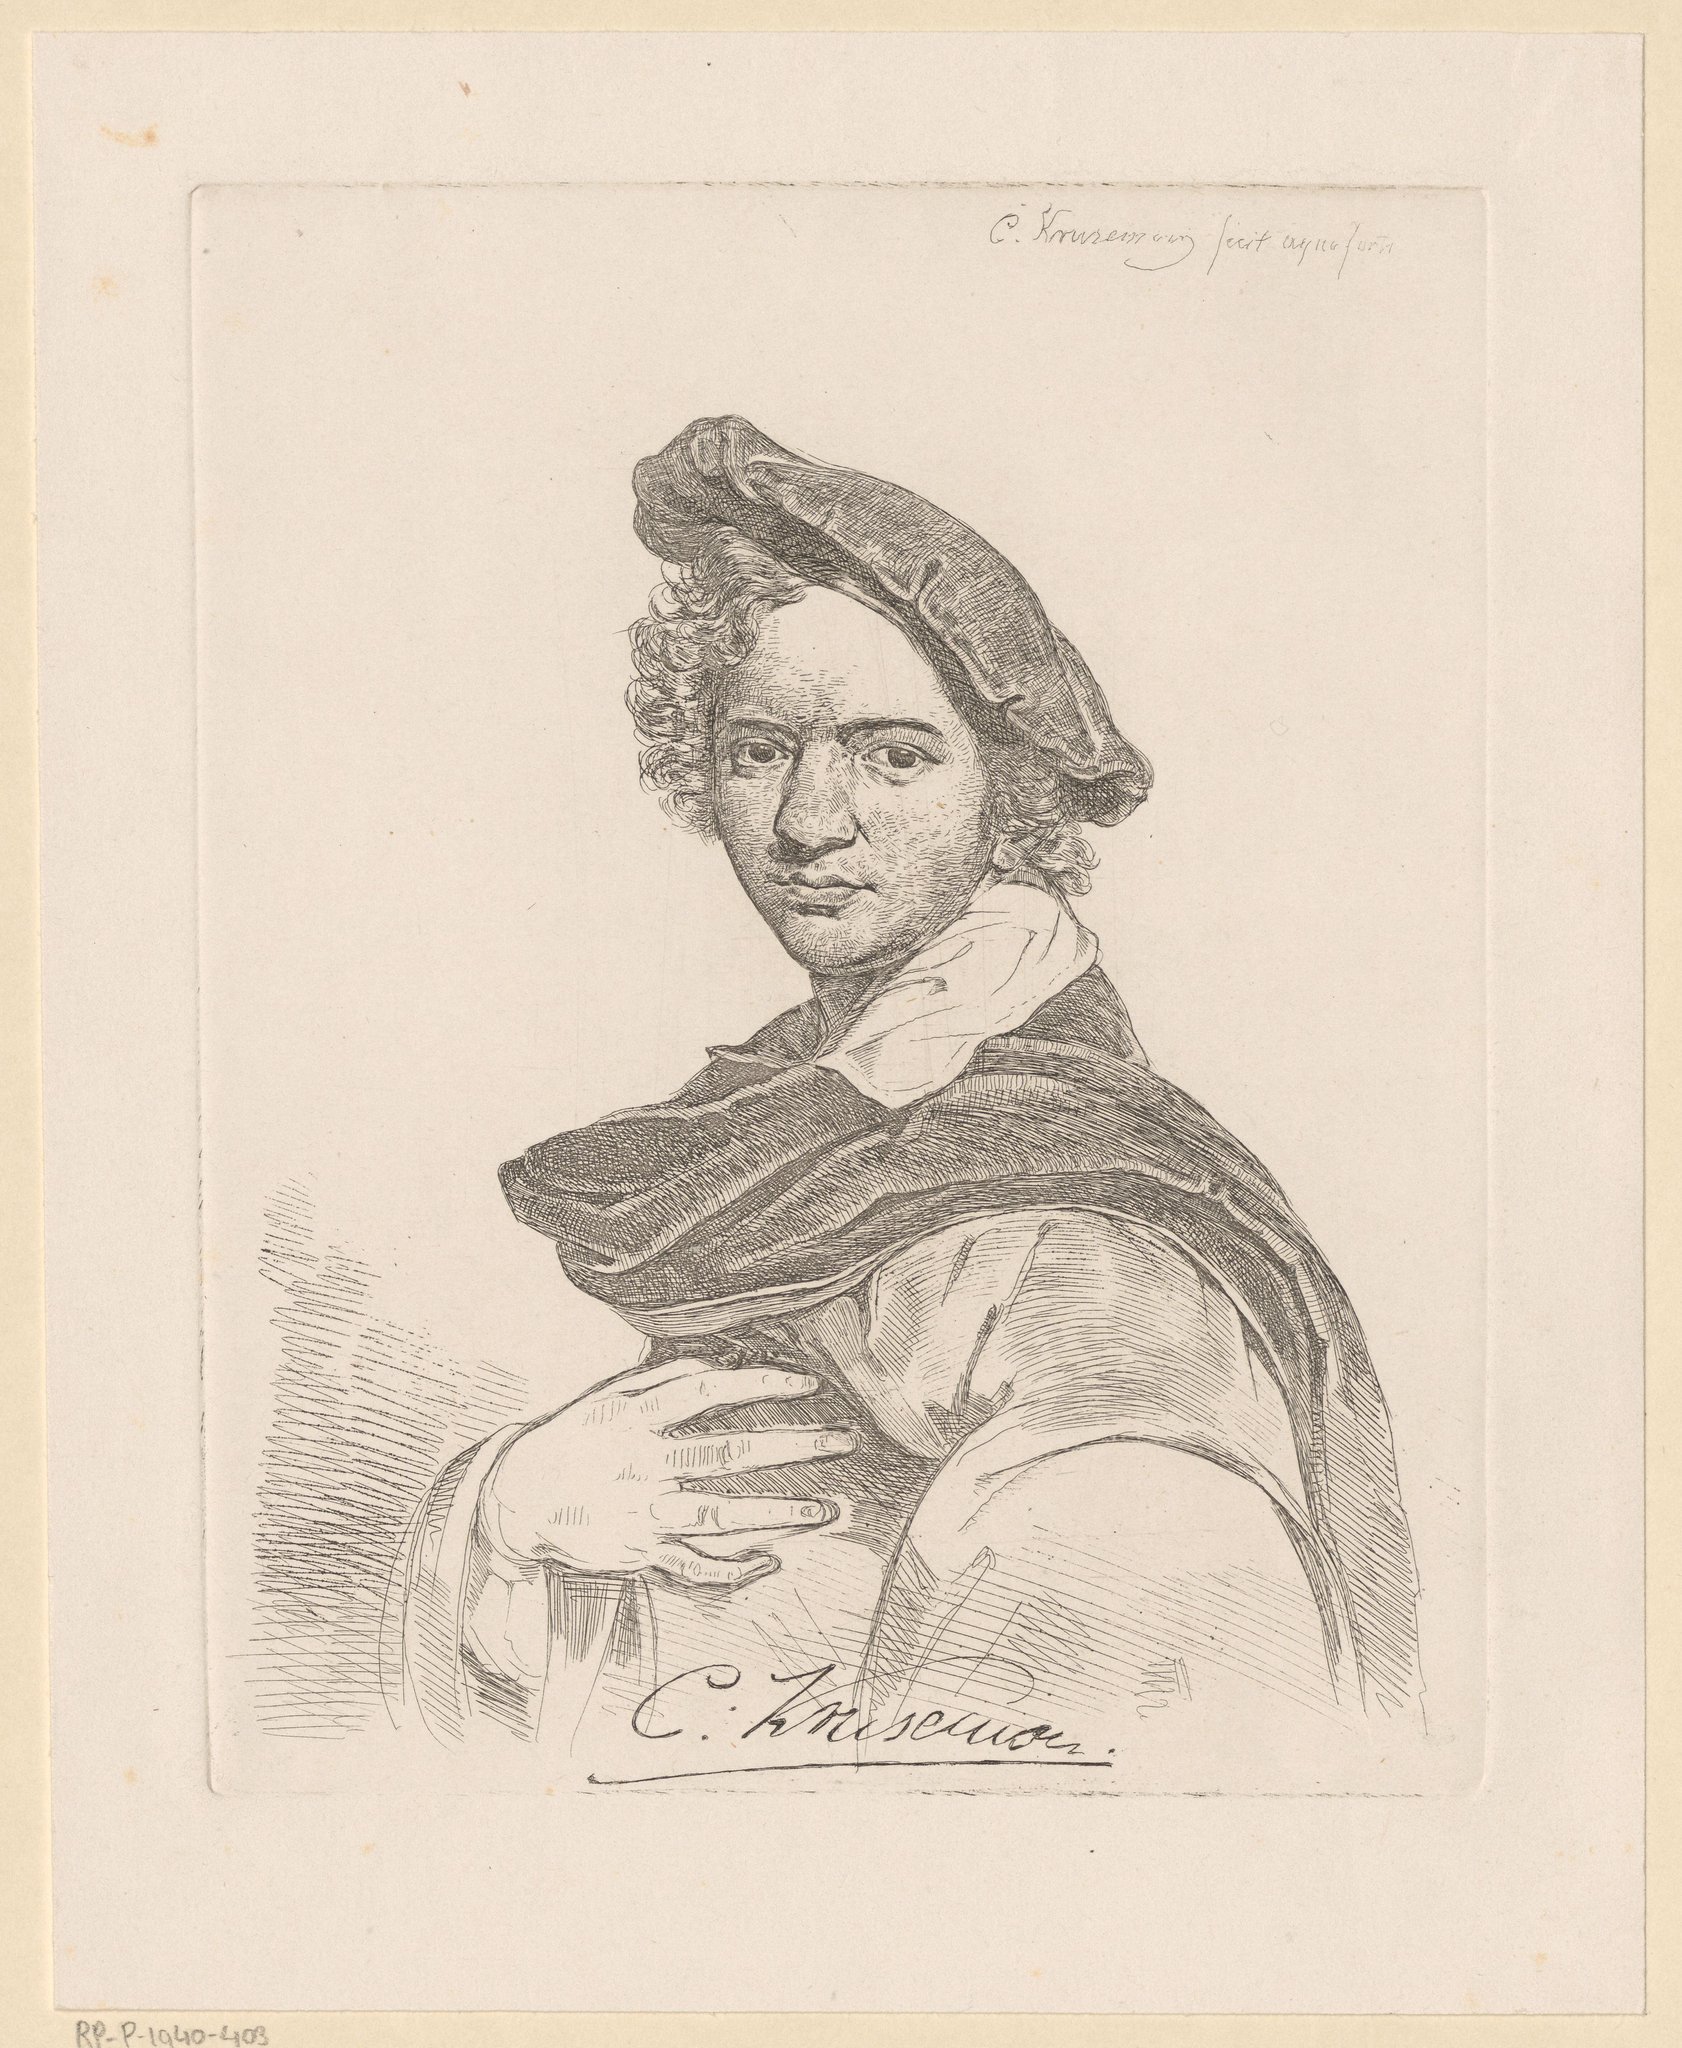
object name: print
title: Zelfportret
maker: cornelis kruseman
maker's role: draughtsman, painter, print maker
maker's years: 1797-1857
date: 1807-1857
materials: paper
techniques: etching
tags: amsterdam, draughtsman, cornelis kruseman, historical persons, portrait, self-portrait of painter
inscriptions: collector's mark: Lugt 2760, collector's mark: Lugt 2228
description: Onder het portret een facsimile van de handtekening van de geportretteerde.